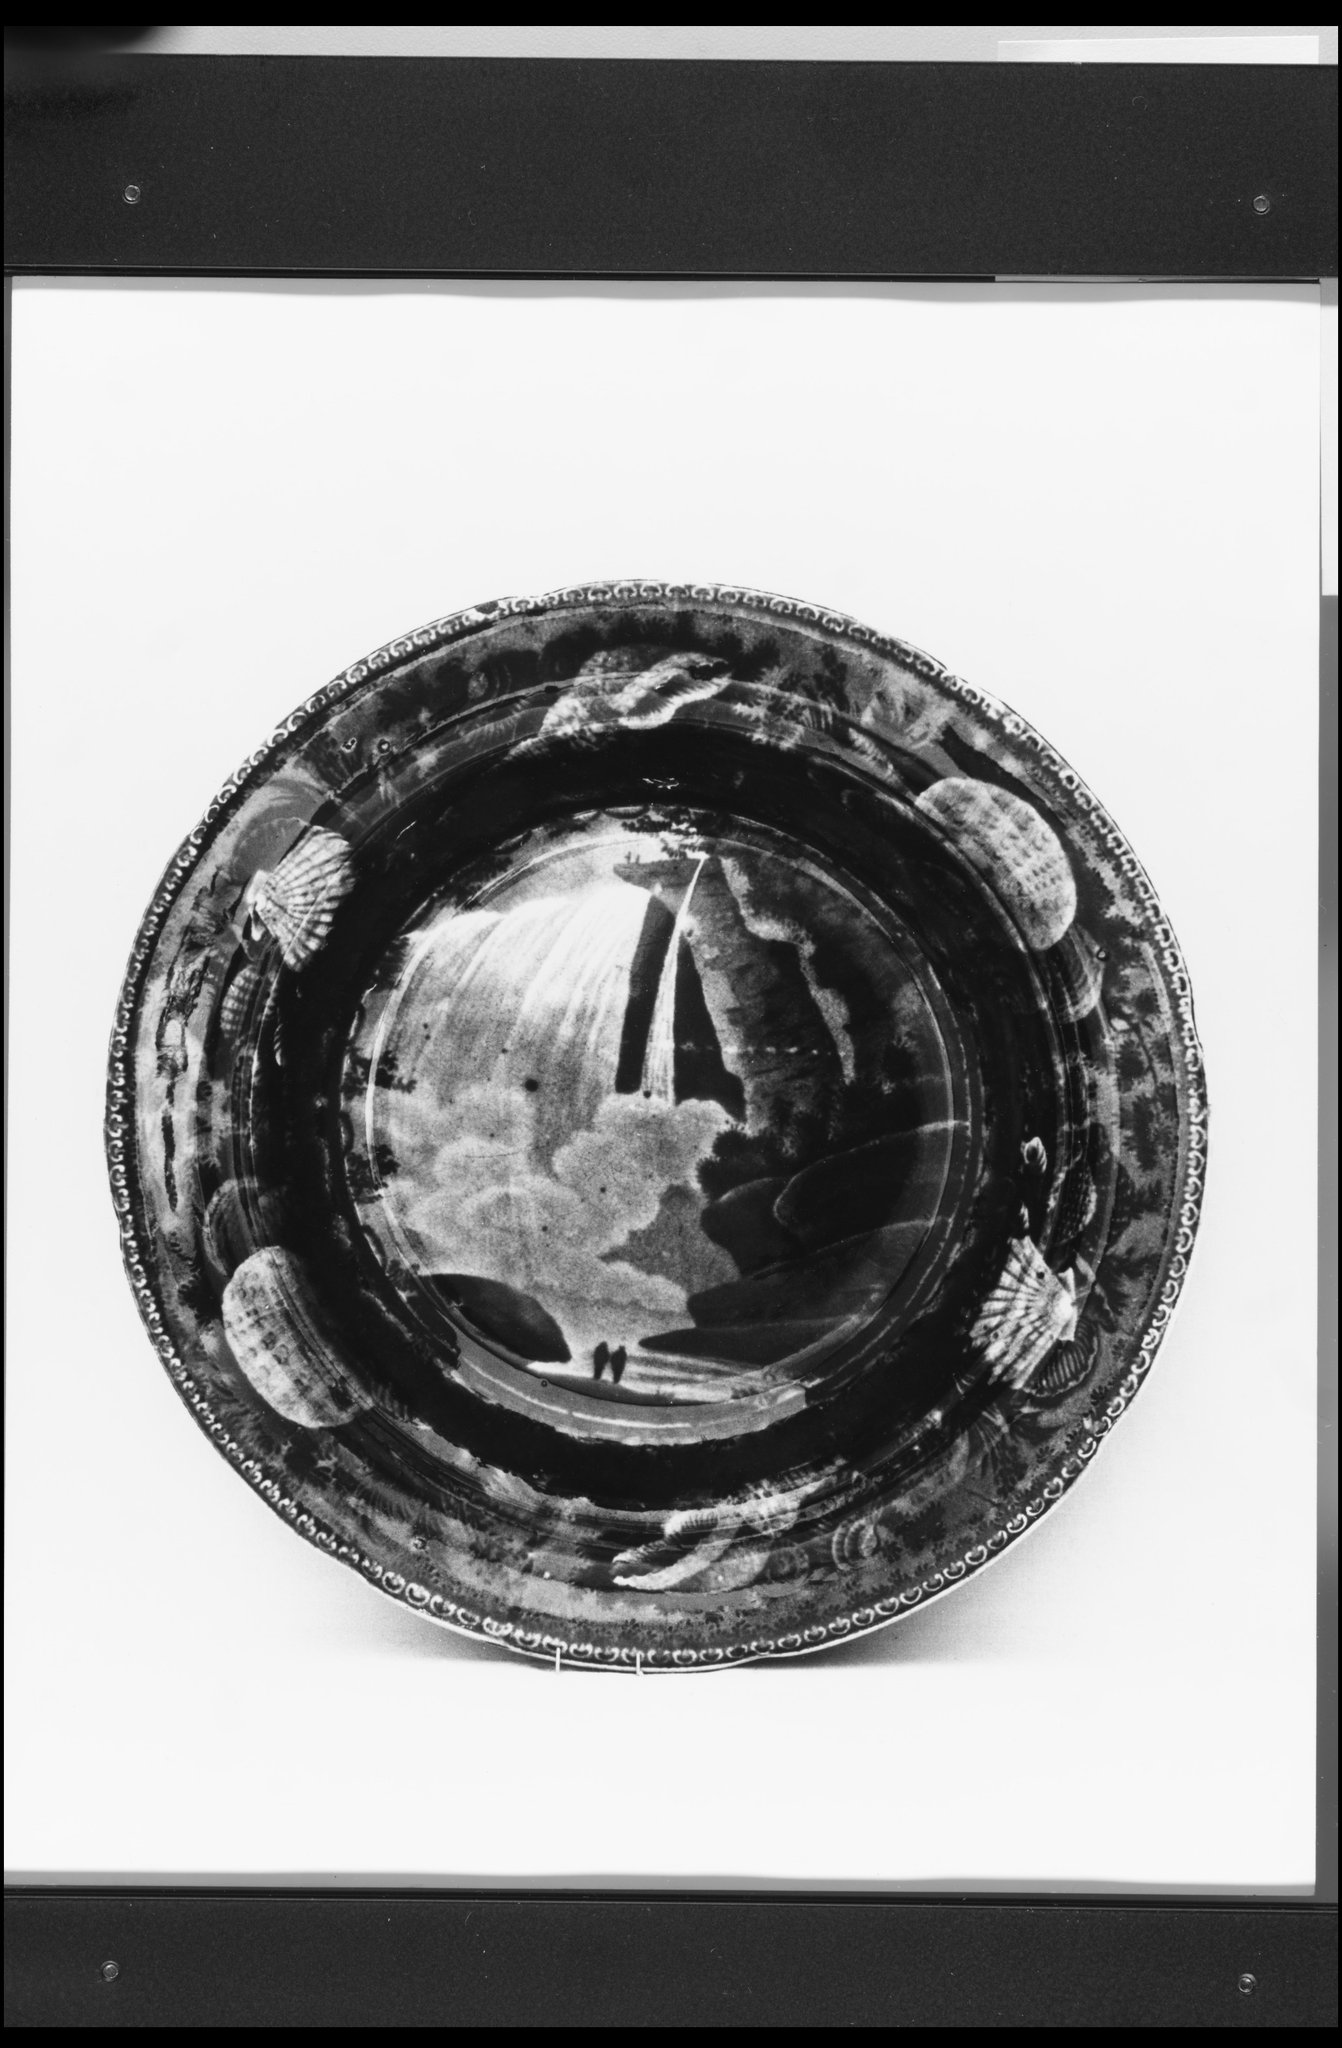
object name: dish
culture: british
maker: enoch wood & sons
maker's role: maker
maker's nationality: british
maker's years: 1818-1846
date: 1818-1846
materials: earthenware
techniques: transfer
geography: england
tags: waterfalls